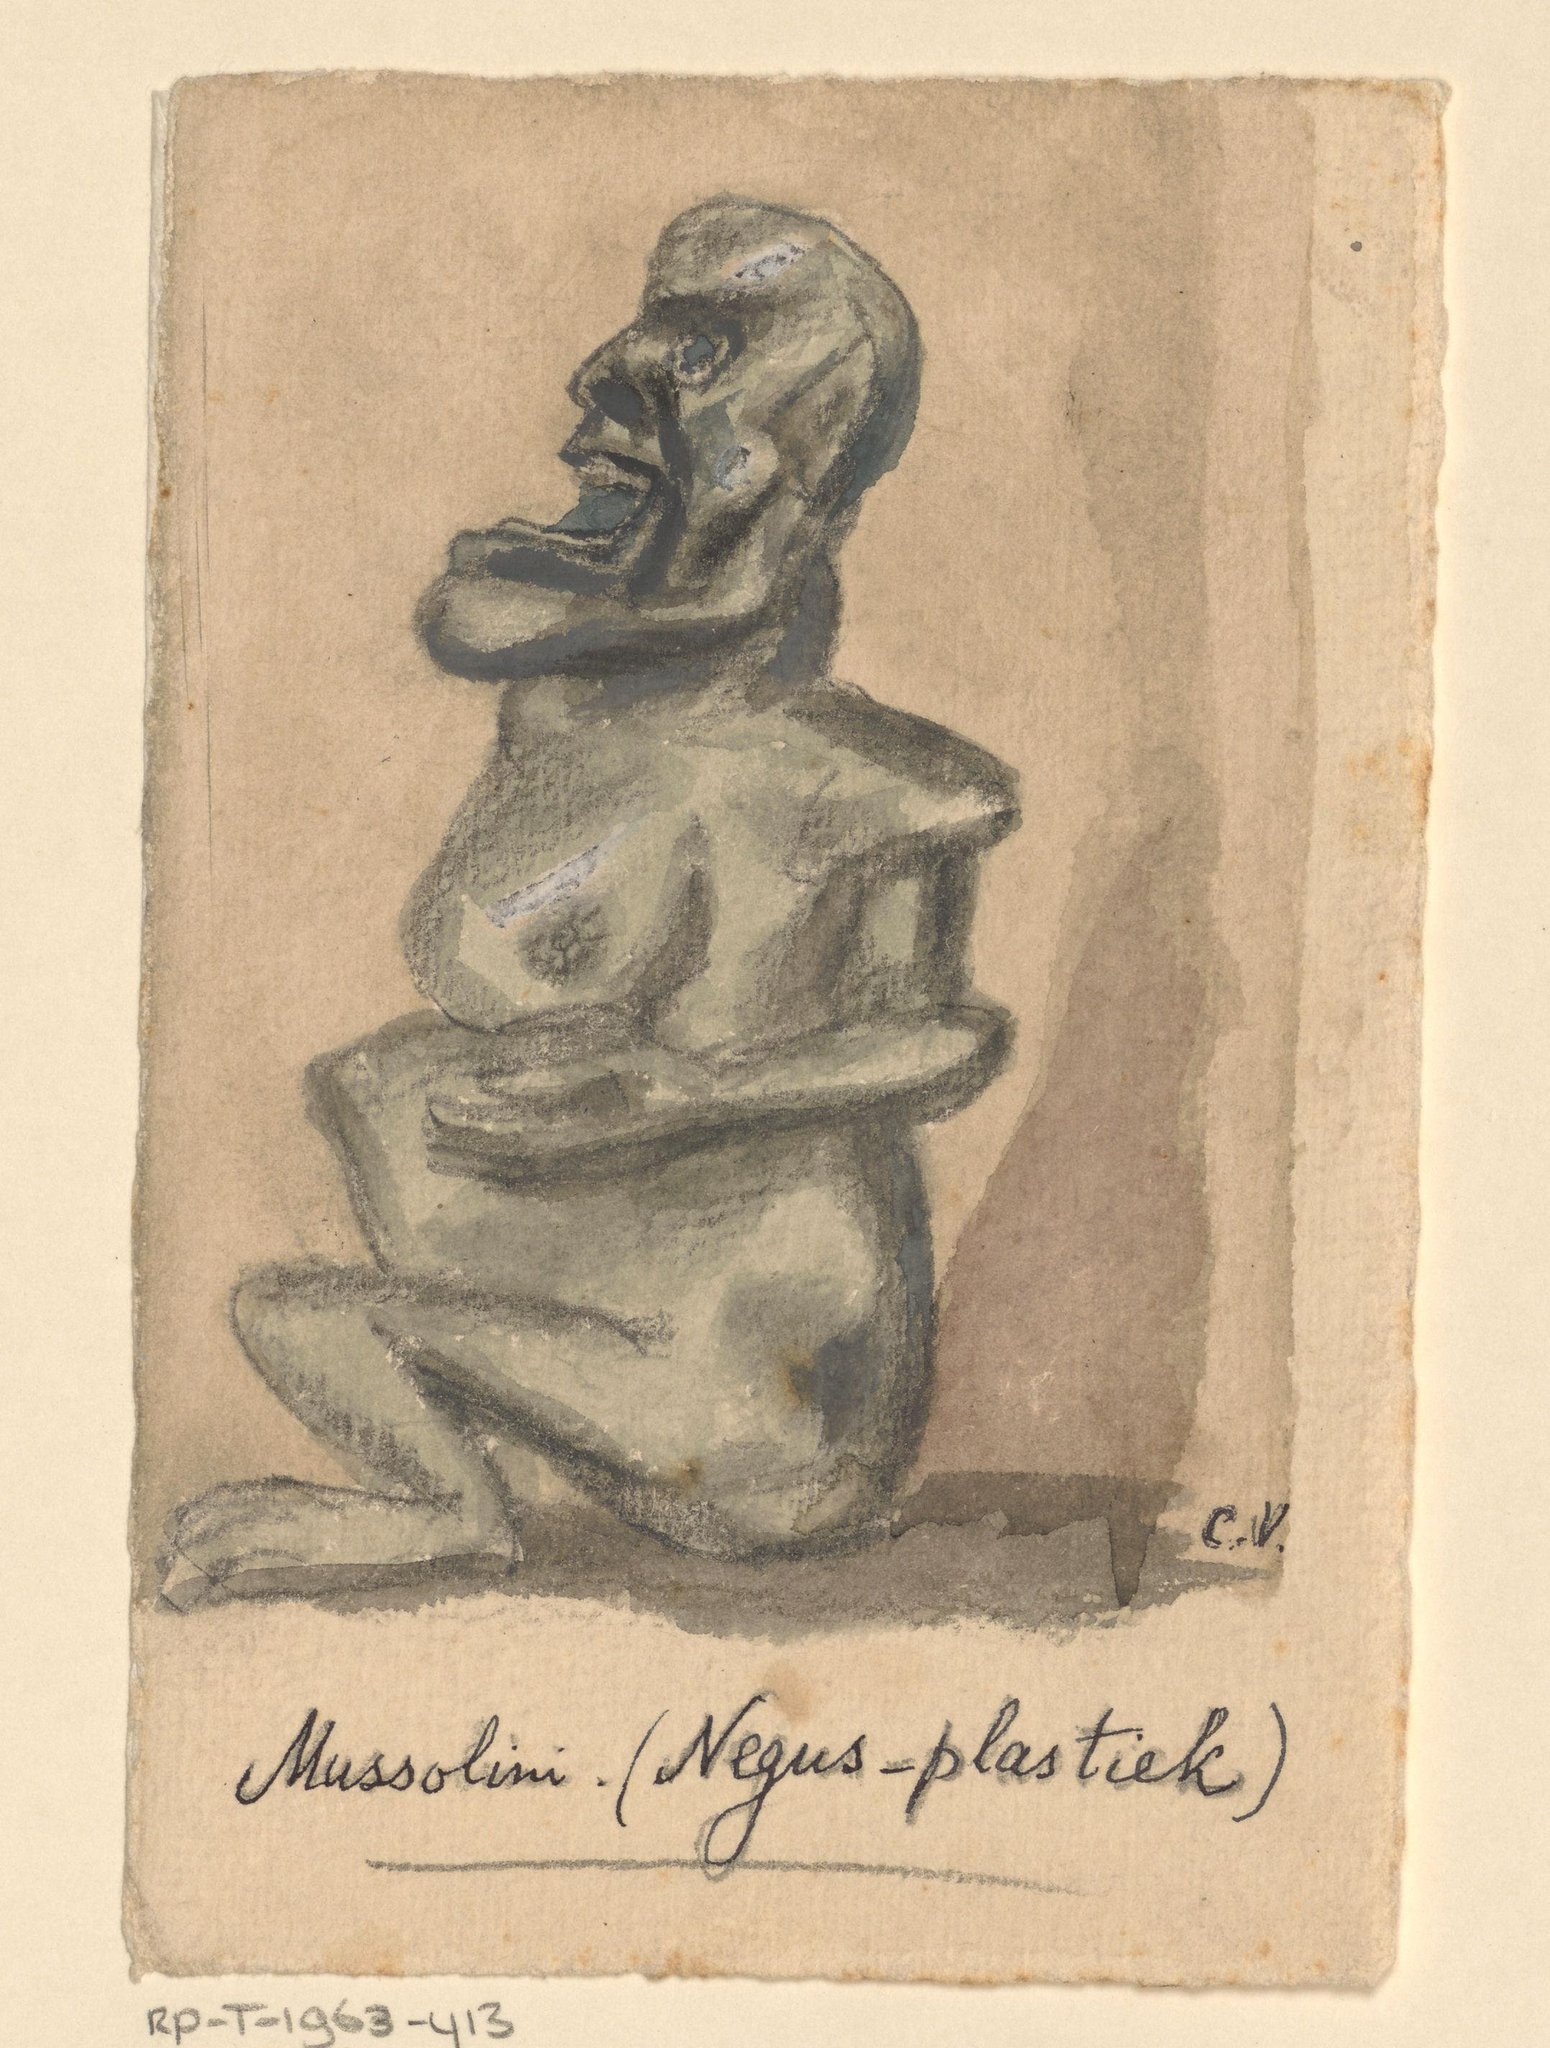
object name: drawing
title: Beeld van Benito Mussolini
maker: cornelis veth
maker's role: draughtsman, print maker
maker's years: 1880-1962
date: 1935-1945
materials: ink, paint, paper, pencil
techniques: brush, letterpress printing, pen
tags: historical persons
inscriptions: collector's mark: Lugt 2228